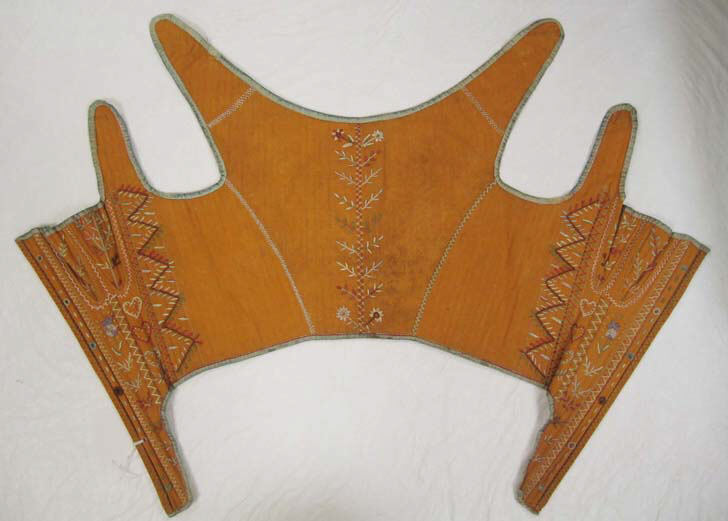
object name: corset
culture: american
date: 1850-1859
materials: cotton, linen, silk